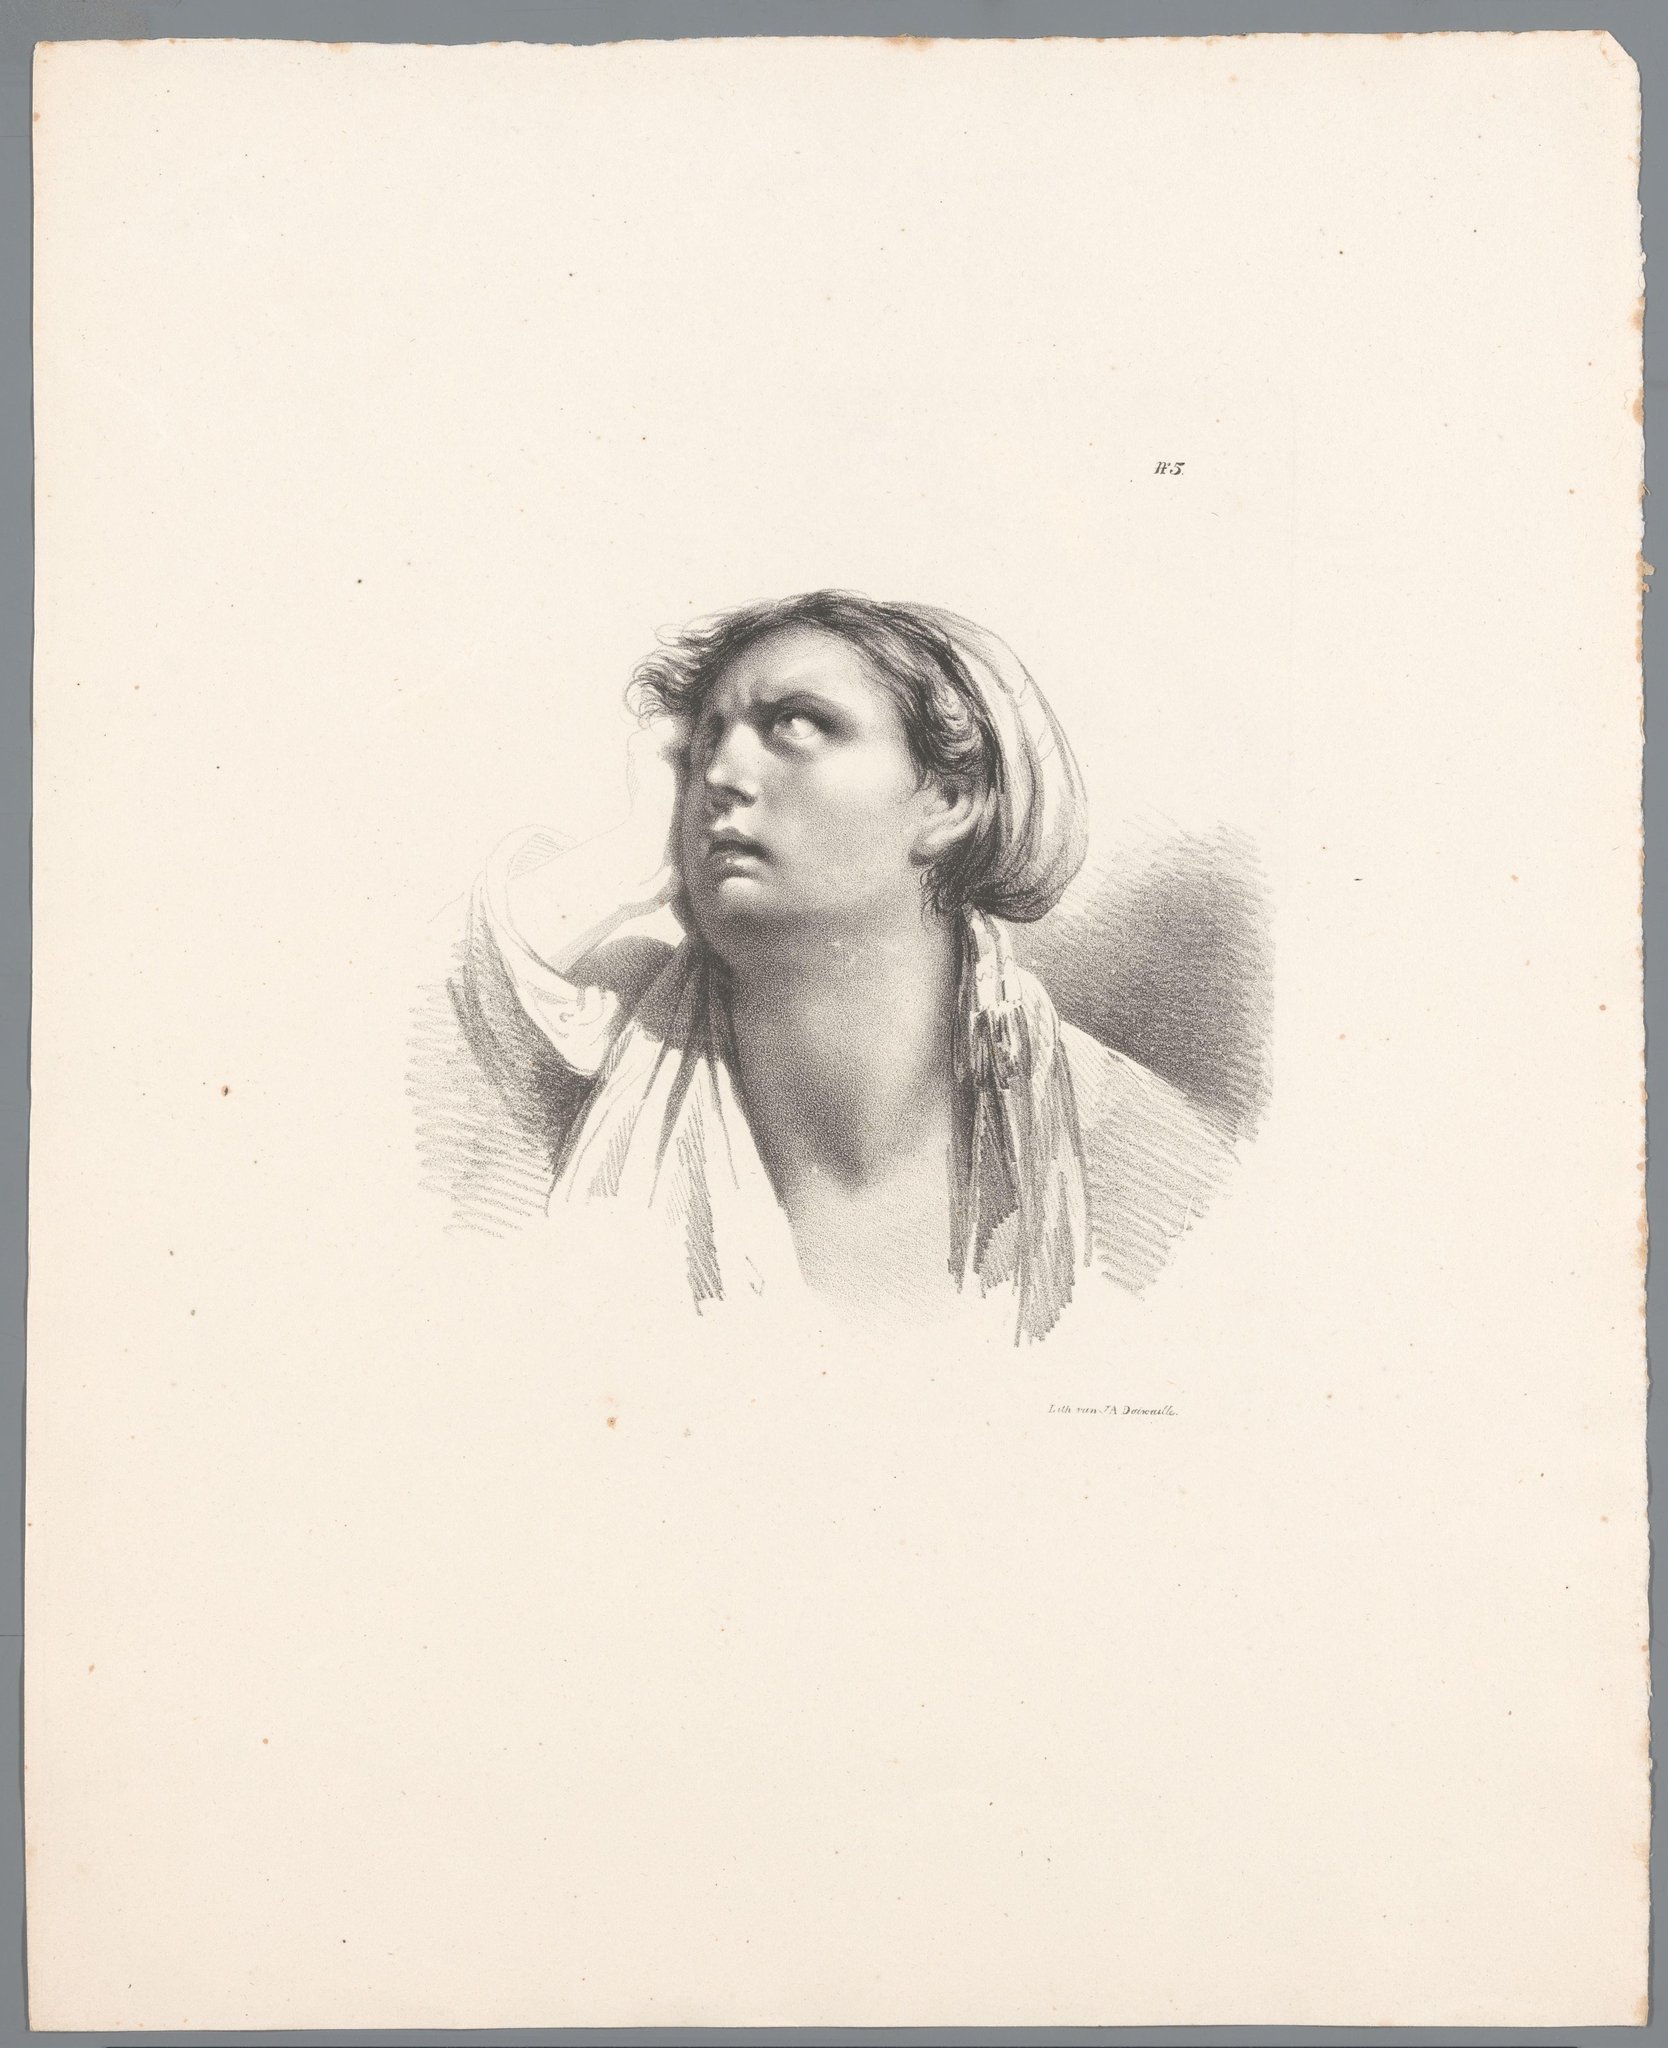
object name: print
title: Hartstochten na J.B. Greuze Nummer Twee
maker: jean augustin daiwaille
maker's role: draughtsman, print maker, printer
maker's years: 1786-1850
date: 1820-1830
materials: paper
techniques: lithograph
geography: amsterdam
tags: head-gear (with name), adult woman (+ relations with aggressive, hostile character (expressive connotations))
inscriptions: collector's mark: Lugt 2228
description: 'Hartstochten na J.B. Greuze' bestaat uit twee of drie genummerde reeksen. (Sommige nummers komen drie keer voor op drie verschillende afbeeldingen.) Binnen deze omslag bevinden zich achttien verschillende afbeeldingen. Mogelijk heeft dit te maken met de twee momenten waarop Daiwaille de reeks uitgaf, ten tijden van zijn directeurschap aan de Rijksakademie in Amsterdam en daarna als zelfstandige. De omslag behoort waarschijnlijk bij een van deze twee series. Zie Marres-Schretlen in het Bulletin van het Rijksmuseum.